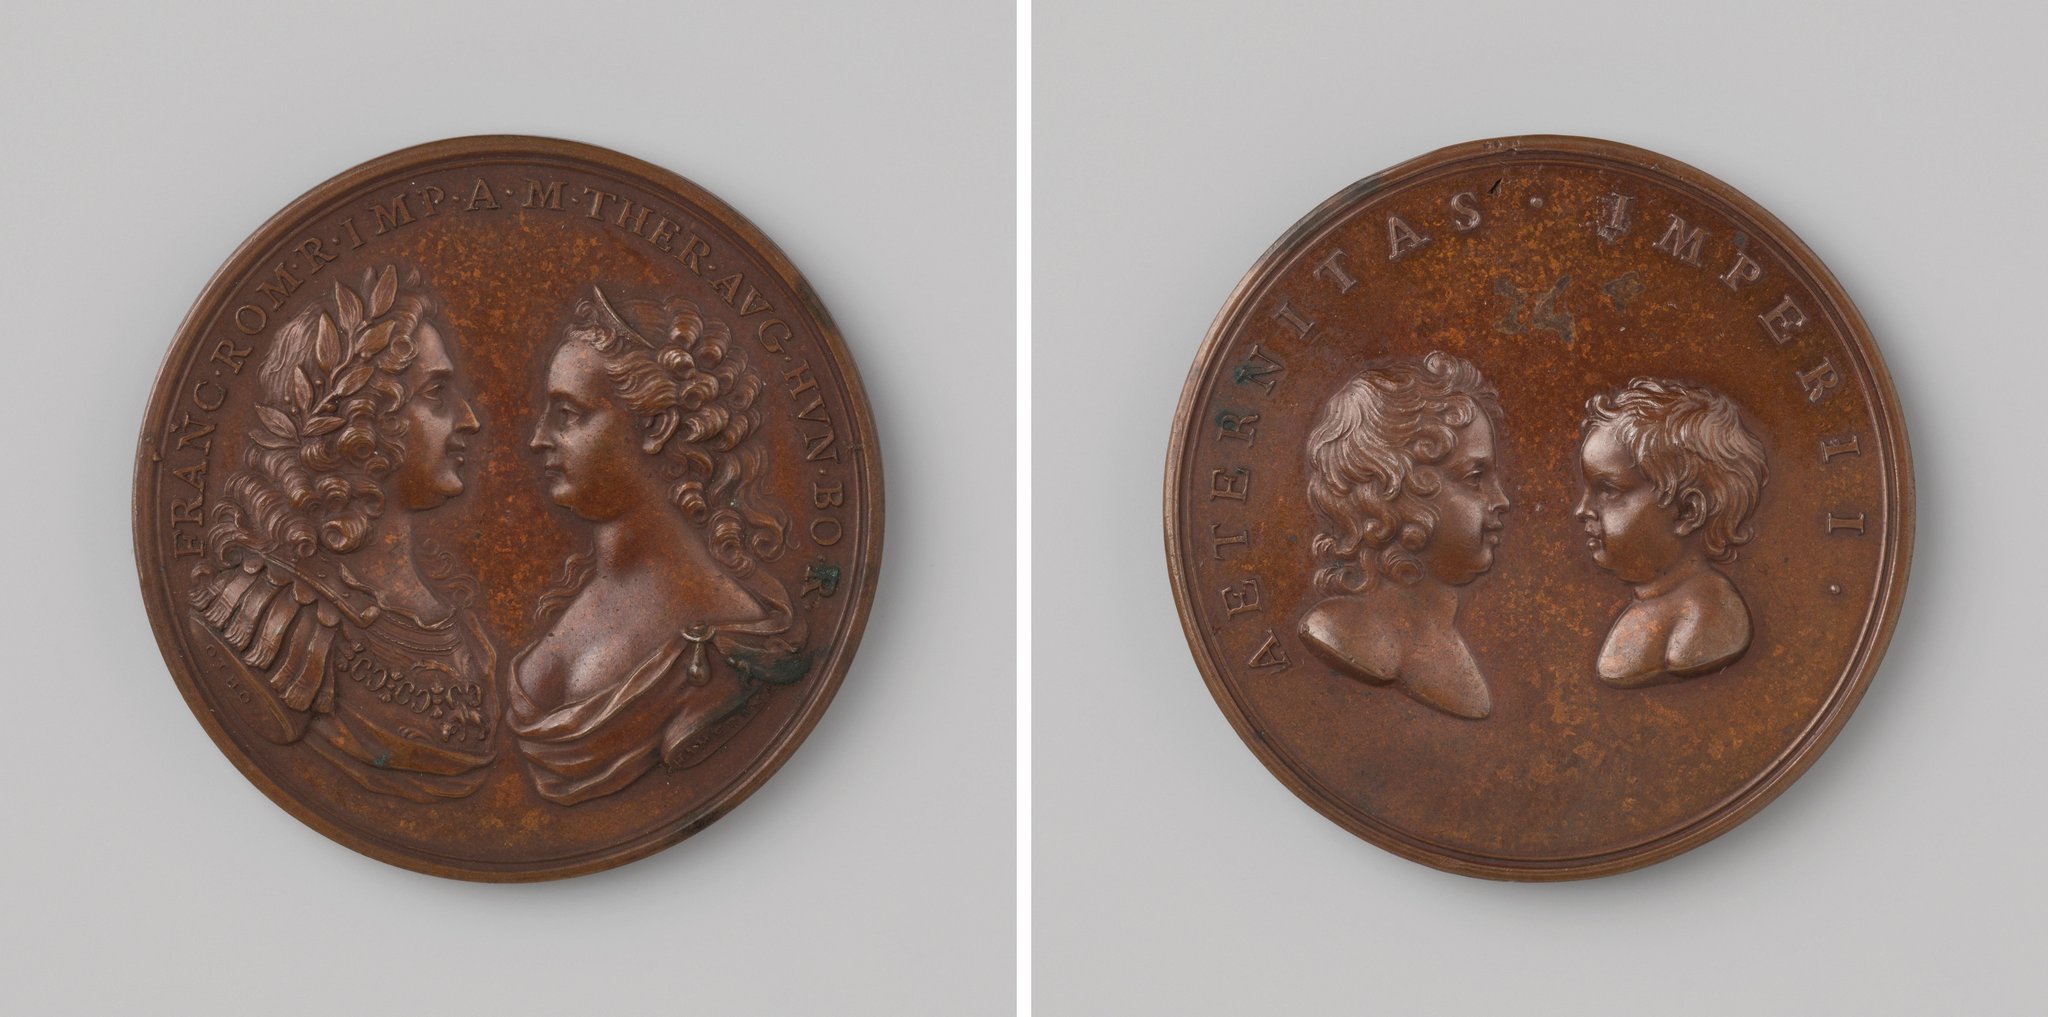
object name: history medal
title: Geboorte van Karel Jozef, aartshertog van Oostenrijk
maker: ottone hamerani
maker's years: 1694-1768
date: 1745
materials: bronze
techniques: striking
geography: rome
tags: vienna, maria theresia (rooms-duits keizerin), jozef ii (duits keizer), frans i stefan (duits keizer)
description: Bronzen penning. Voorzijde: naar elkaar gewende borststukken van man met lauwerkrans en vrouw met diadeem binnen omschrift. Keerzijde: naar elkaar gewende borststukken van twee kinderen binnen omschrift